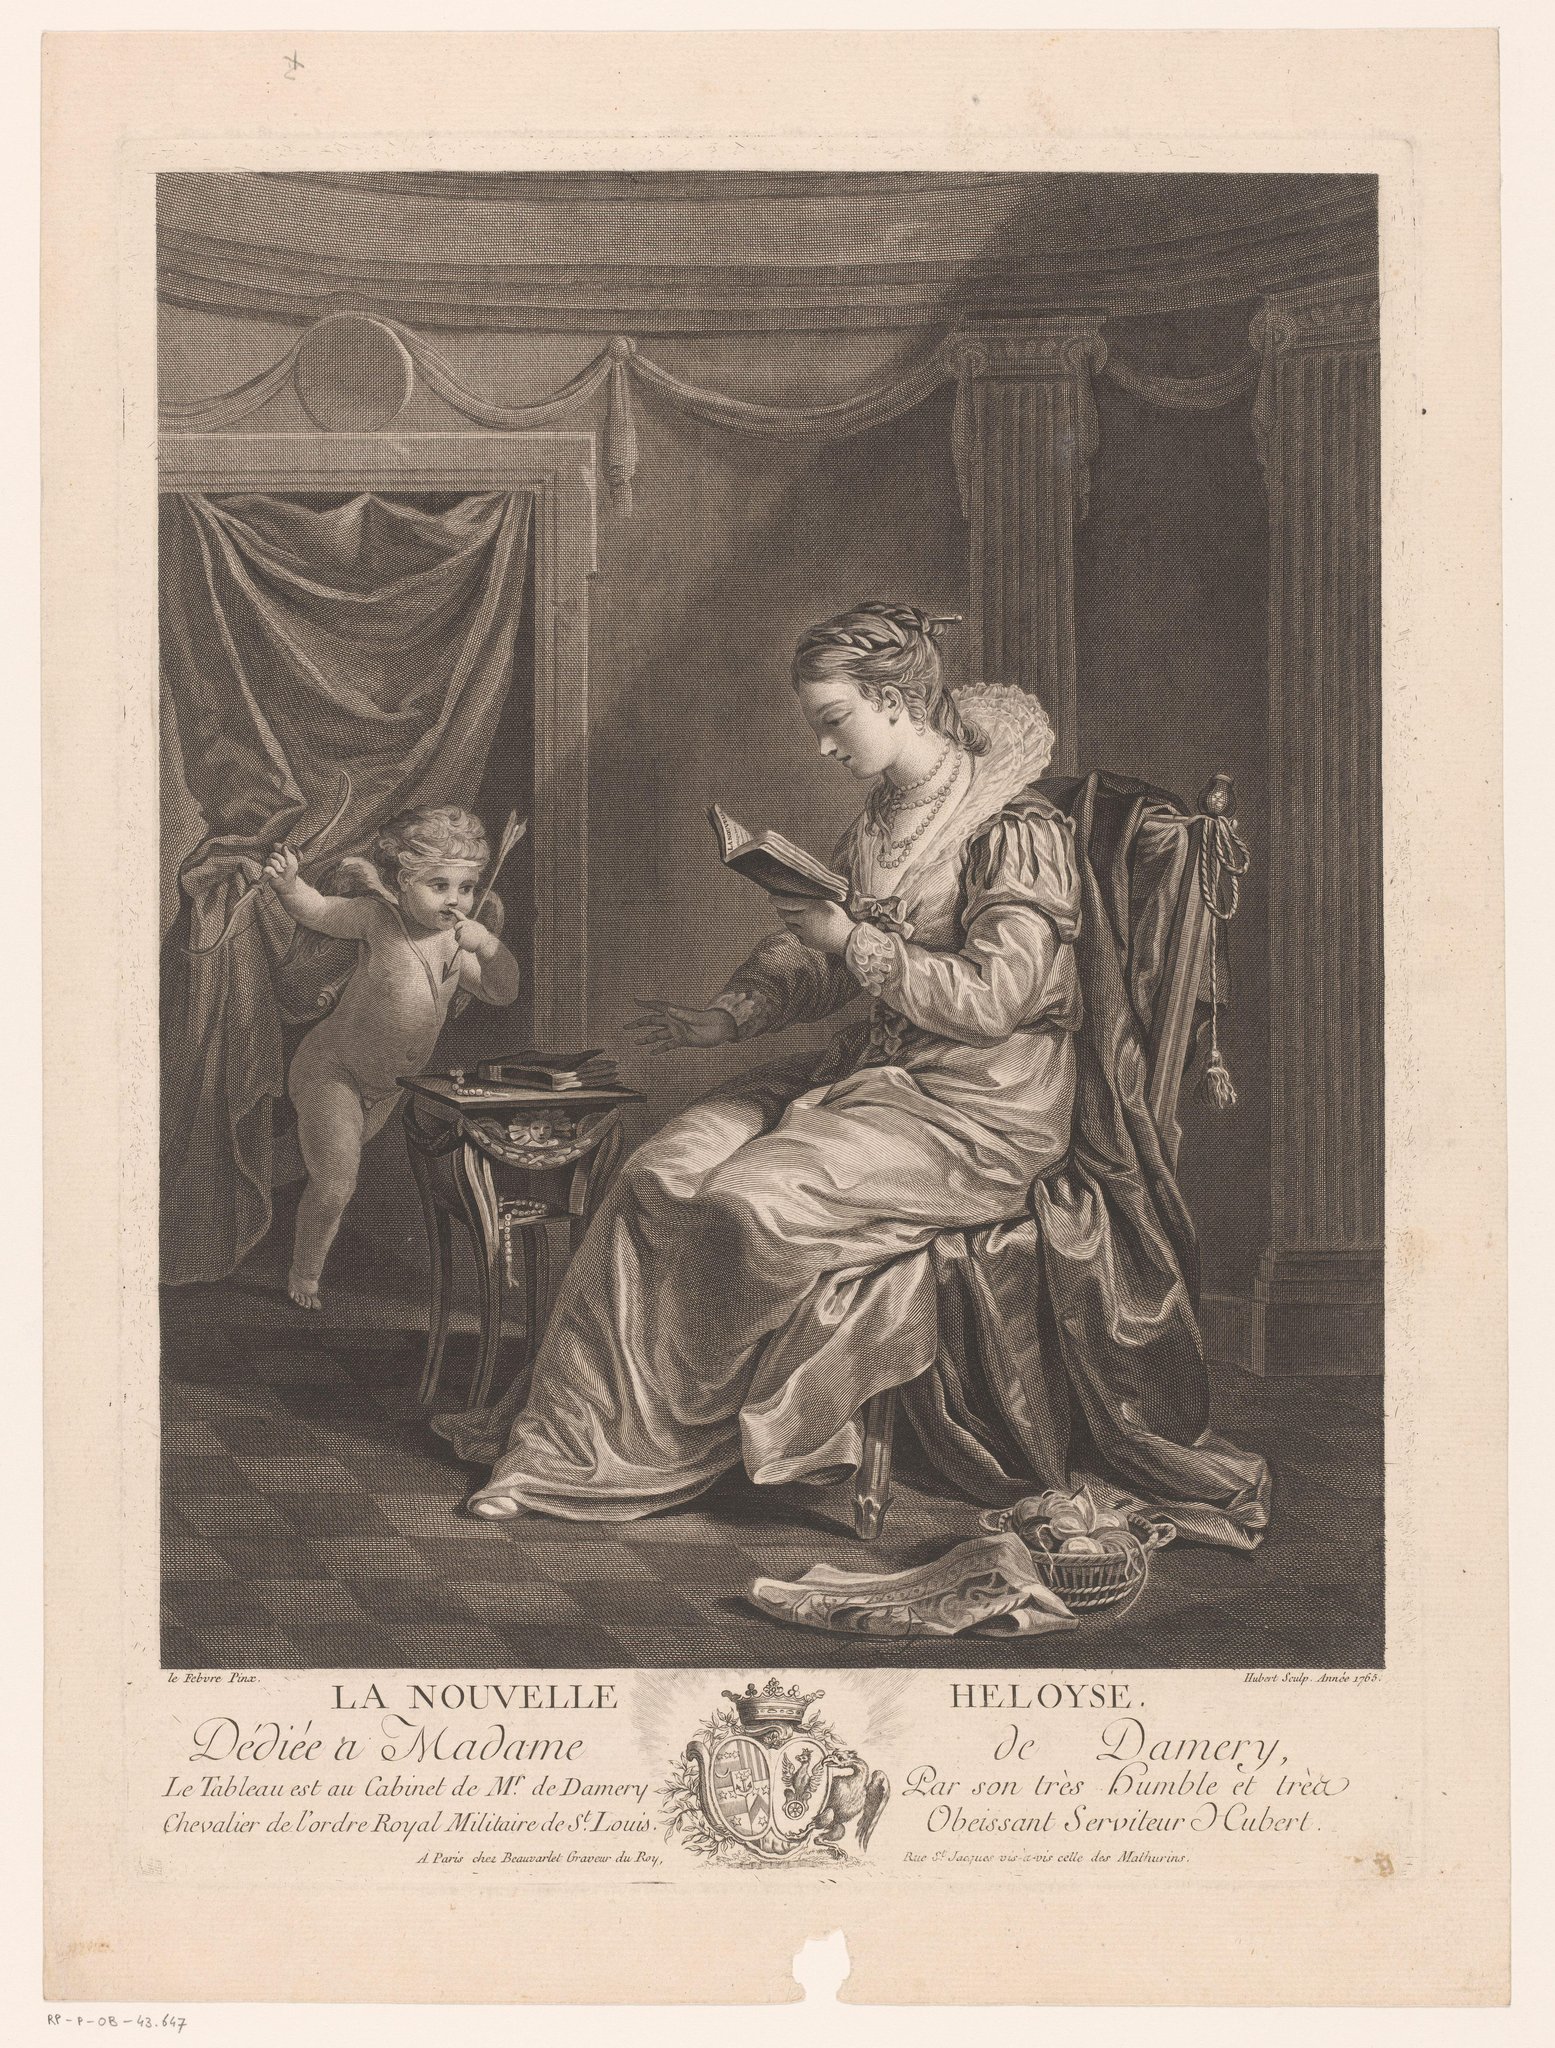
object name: print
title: La Nouvelle Heloyse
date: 1765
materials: paper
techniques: engraving, etching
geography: paris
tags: reading, (story of) cupid, amor (eros)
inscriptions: date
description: Interieur met een vrouw gezeten op een stoel. Zij leest 'Julie, ou la nouvelle Héloïse' door Rousseau. Links komt Amor met pijl en boog door een deuropening gelopen.